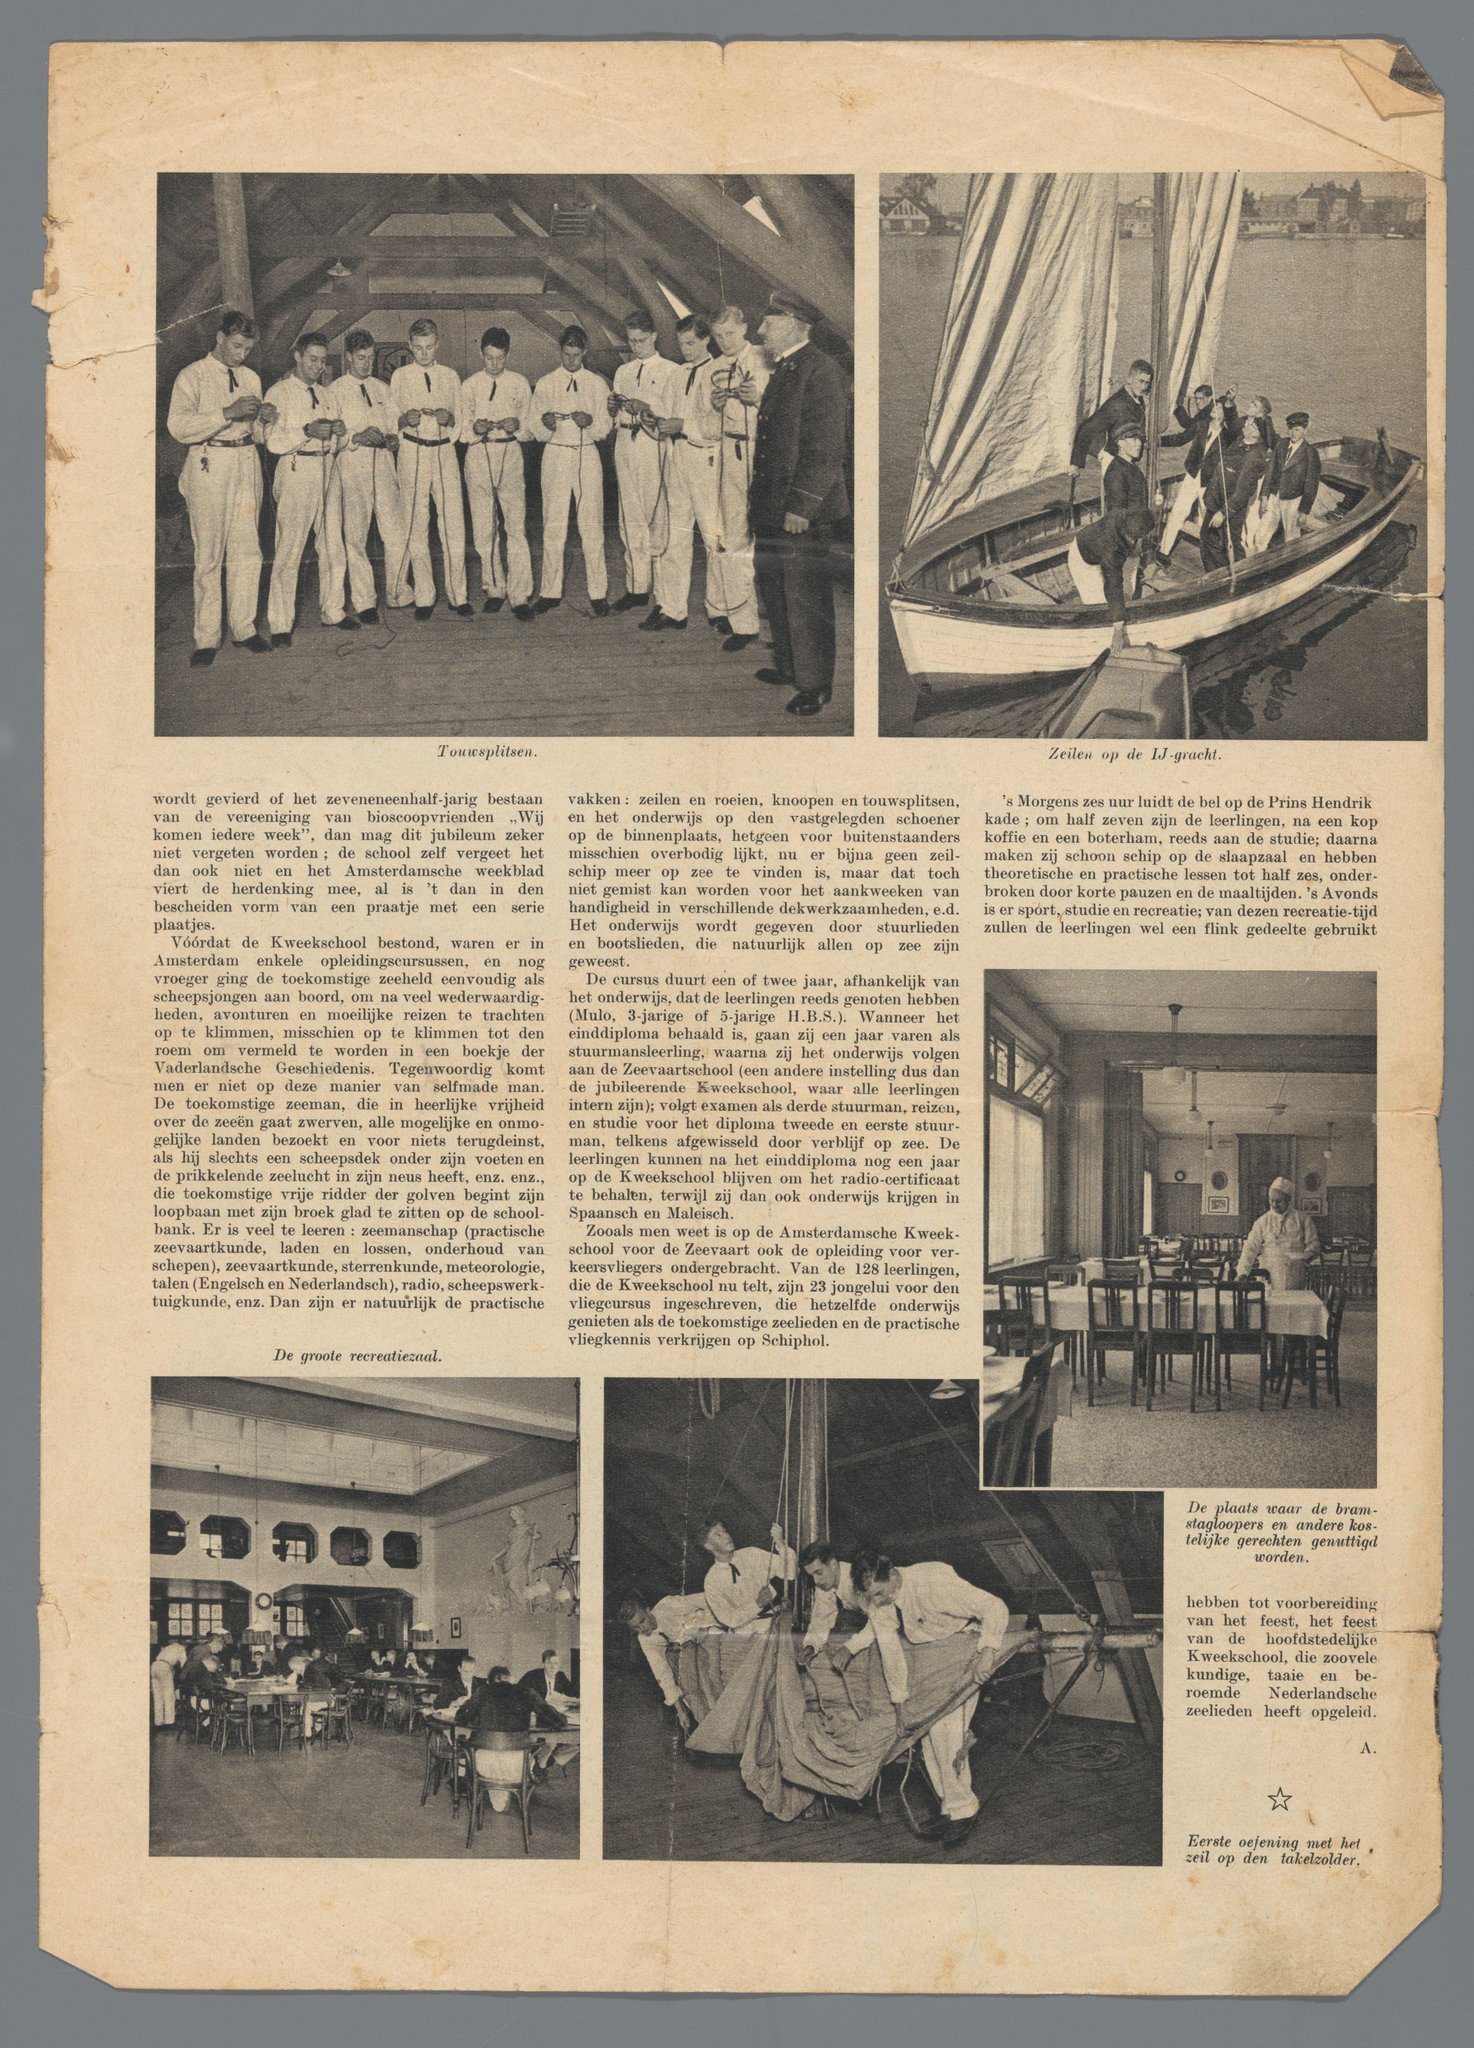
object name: magazine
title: Panorama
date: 1925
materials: paper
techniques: printing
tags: a. happé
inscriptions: date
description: 4 pp (1 vel papier) uit een tijdschrift (Panorama), met afbeelding van A. Happé op de tentoonstelling in AMJV-gebouw te Amsterdam ter herinnering van de 100ste geboortedag van Paul Krüger, october 1925.